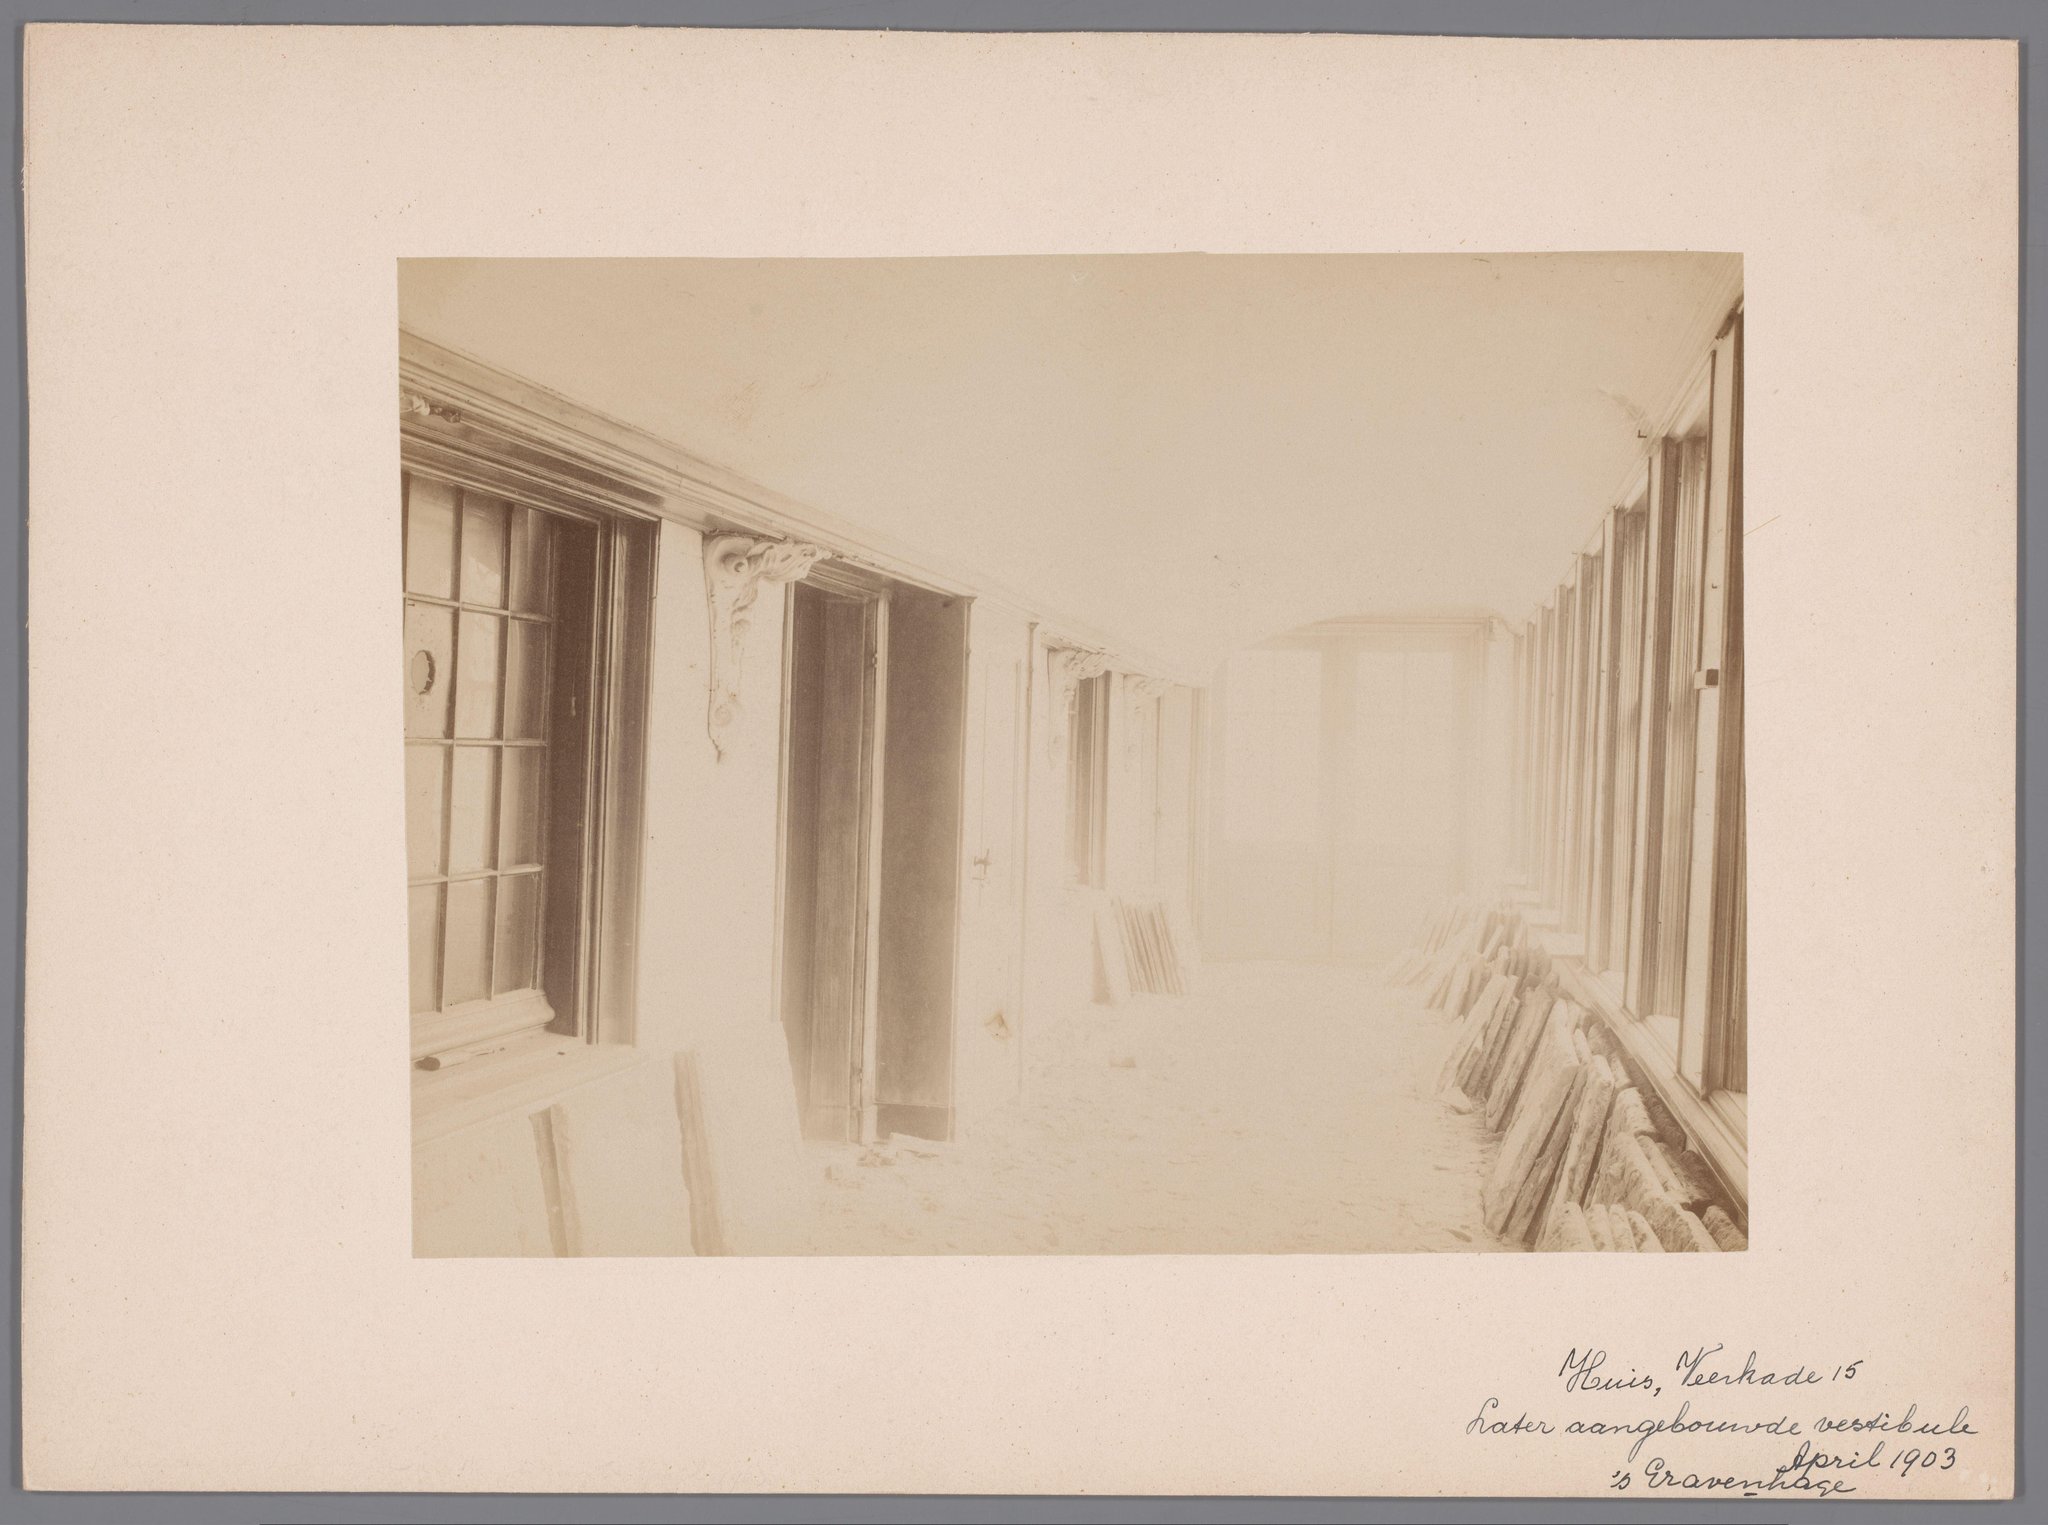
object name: photograph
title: Interieur van de vestibule van Veerkade 15 te Den Haag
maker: anoniem (monumentenzorg)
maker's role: fotograaf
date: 1903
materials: cardboard, photographic support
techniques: albumen print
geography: the hague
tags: vestibule, hall, the hague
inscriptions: annotation: ‘Huis, Veerkade 15/ later aangebouwde verstibule/ April 1903/ 's Gravenhage’, annotation: ‘'s Gravenhage (Z.H.)/ huis Veerkade No.15/ Later aangebouwde vestibule/ geph. & afgebroken. april 1903’, collector's mark: ‘R:MUS.’ Lugt 2228